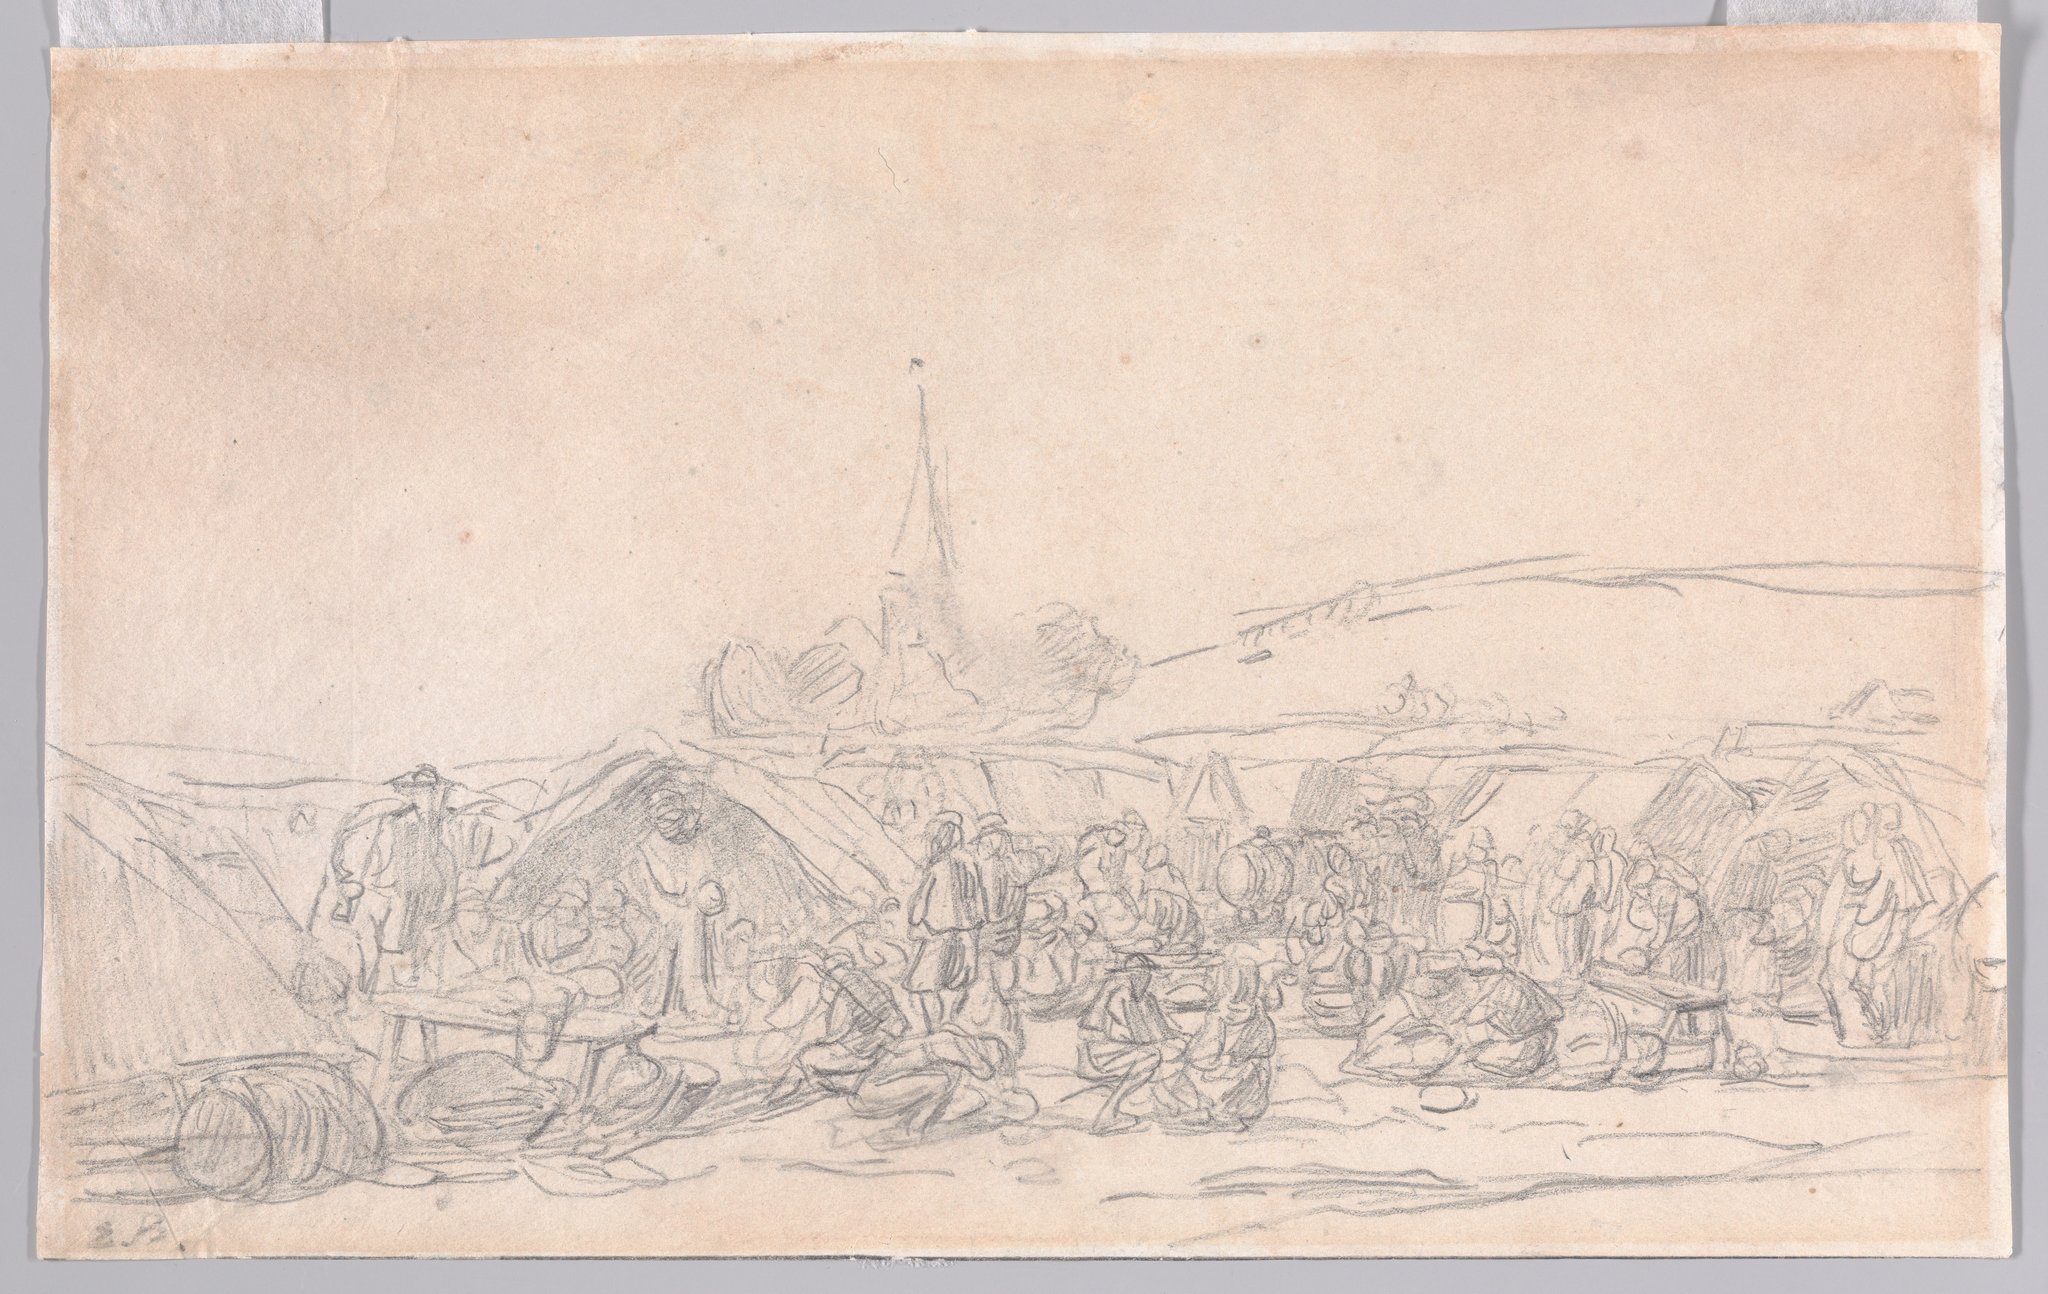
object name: drawing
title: The Pardon of Saint-Anne-La-Palud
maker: eugène boudin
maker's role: artist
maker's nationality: french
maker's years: 1824-1898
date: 1858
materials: graphite